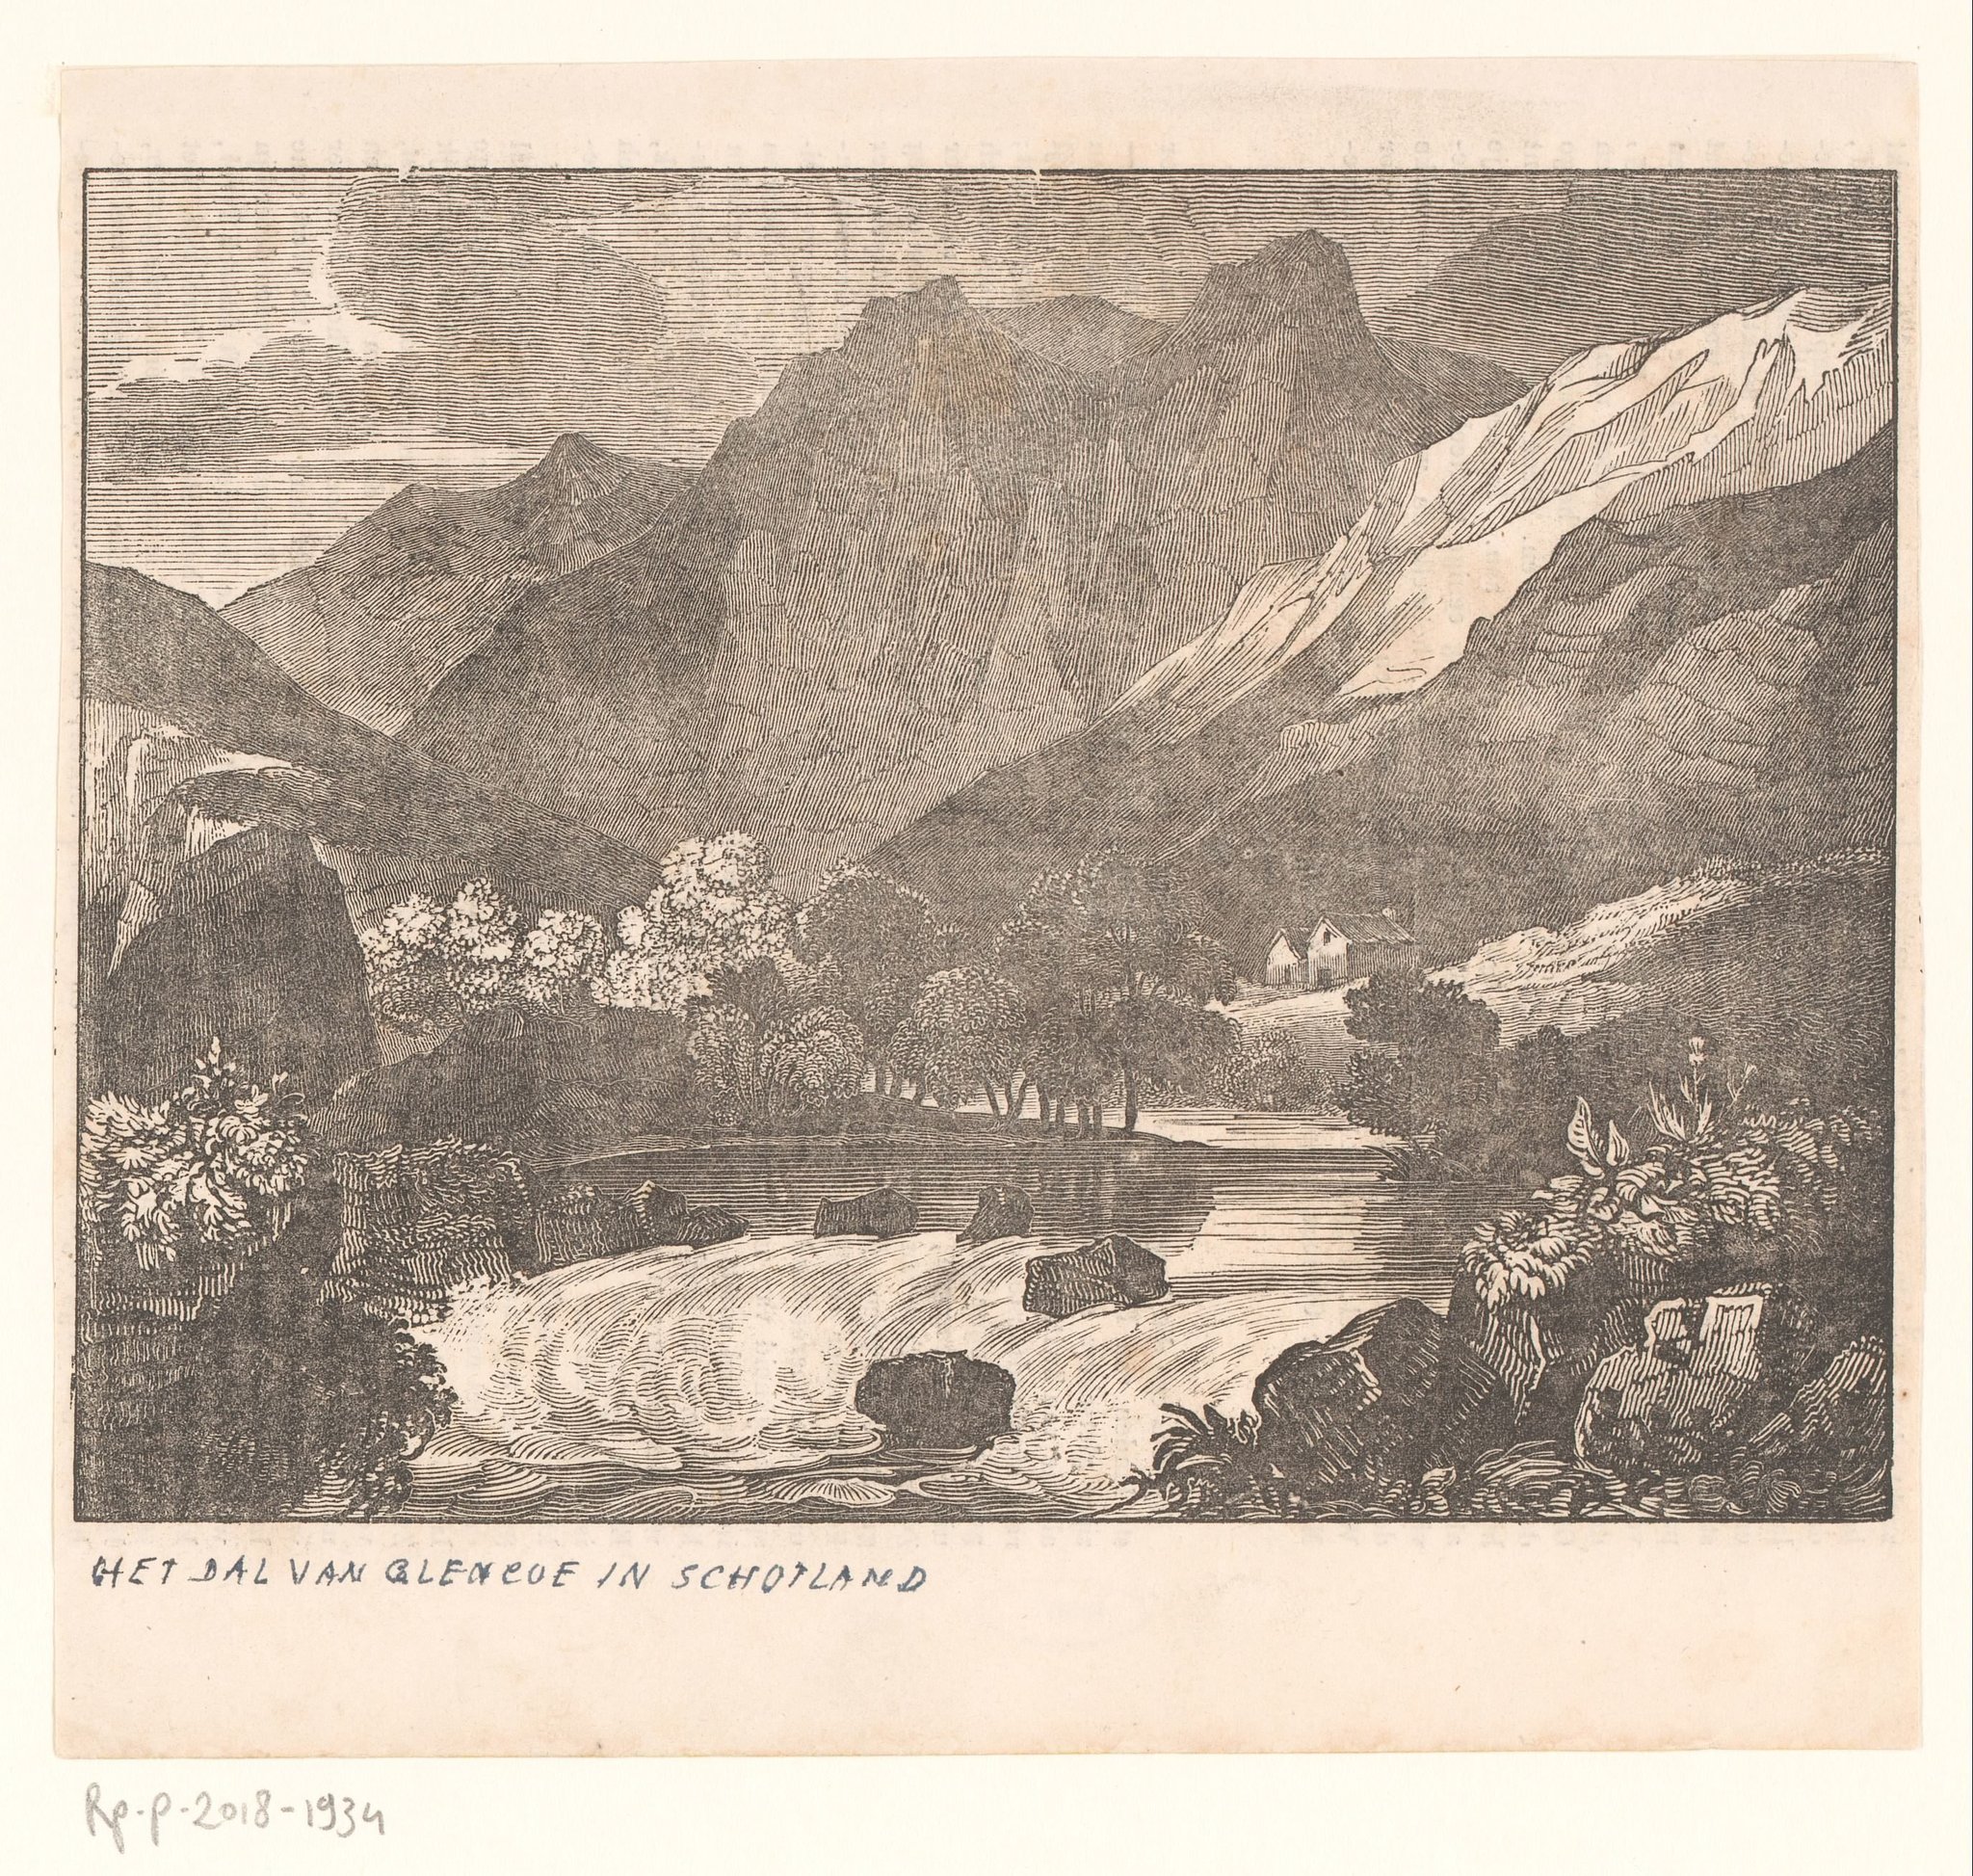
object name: print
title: Gezicht op het dal van Glen Coe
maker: Anonymous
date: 1837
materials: paper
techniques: letterpress printing, engraving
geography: amsterdam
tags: dale, valley, river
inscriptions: collector's mark: Lugt 2228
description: Prent gebruikt in: Nederlandsch Magazijn ter verspreiding van algemeene en nuttige kundigheden. Amsterdam: Gebroeders Diederichs, 1837.